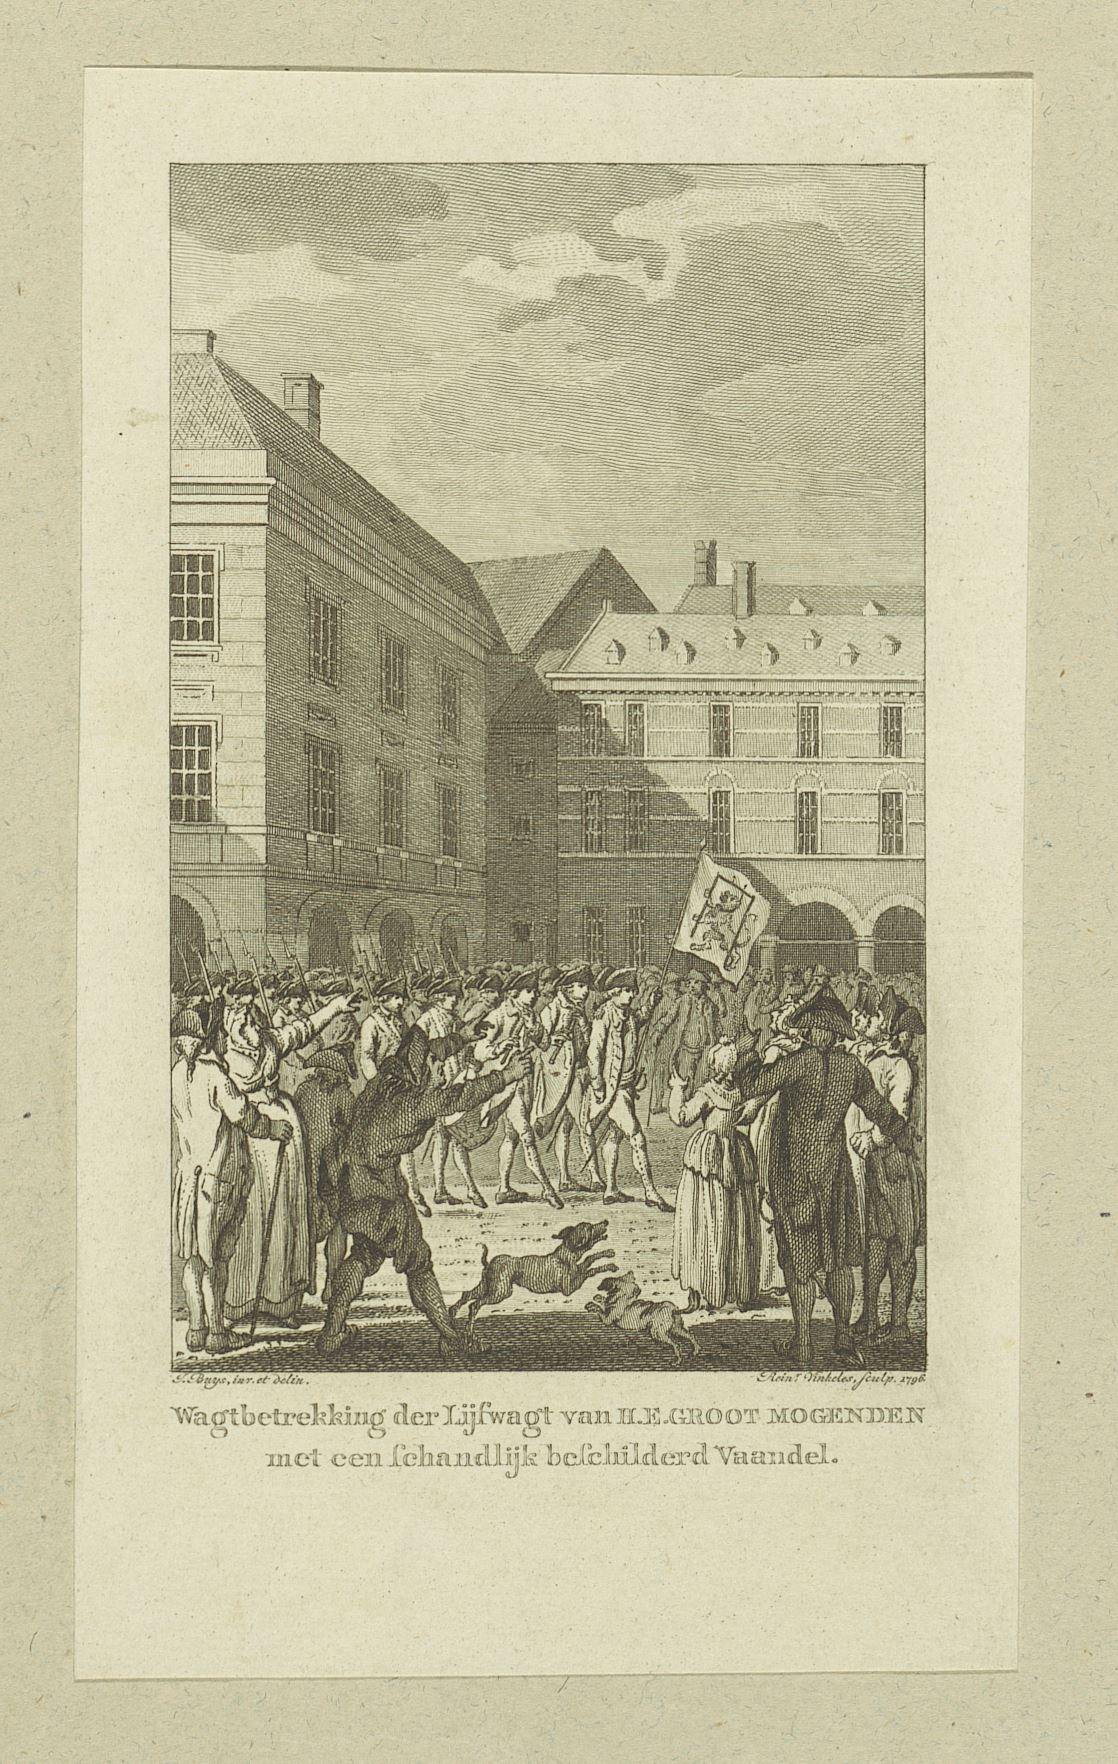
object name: print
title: Optrekken van de wacht op het Binnenhof met een schandelijk vaandel, 1787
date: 1796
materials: paper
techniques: engraving, etching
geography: northern netherlands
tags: drill ~ military training, patriots (1780-1795)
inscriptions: date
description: Huidige staat van prent ook gebruikt in: Loosjes, P.A. Vaderlandsche historie, vervattende de geschiedenissen der Vereenigde Nederlanden (…) Ten vervolge van Wagenaars Vaderlandsche historie. 48 delen. Amsterdam: Johannes Allart, 1786-1811, dl. 16 (1796), tussen p. 94 en 95.